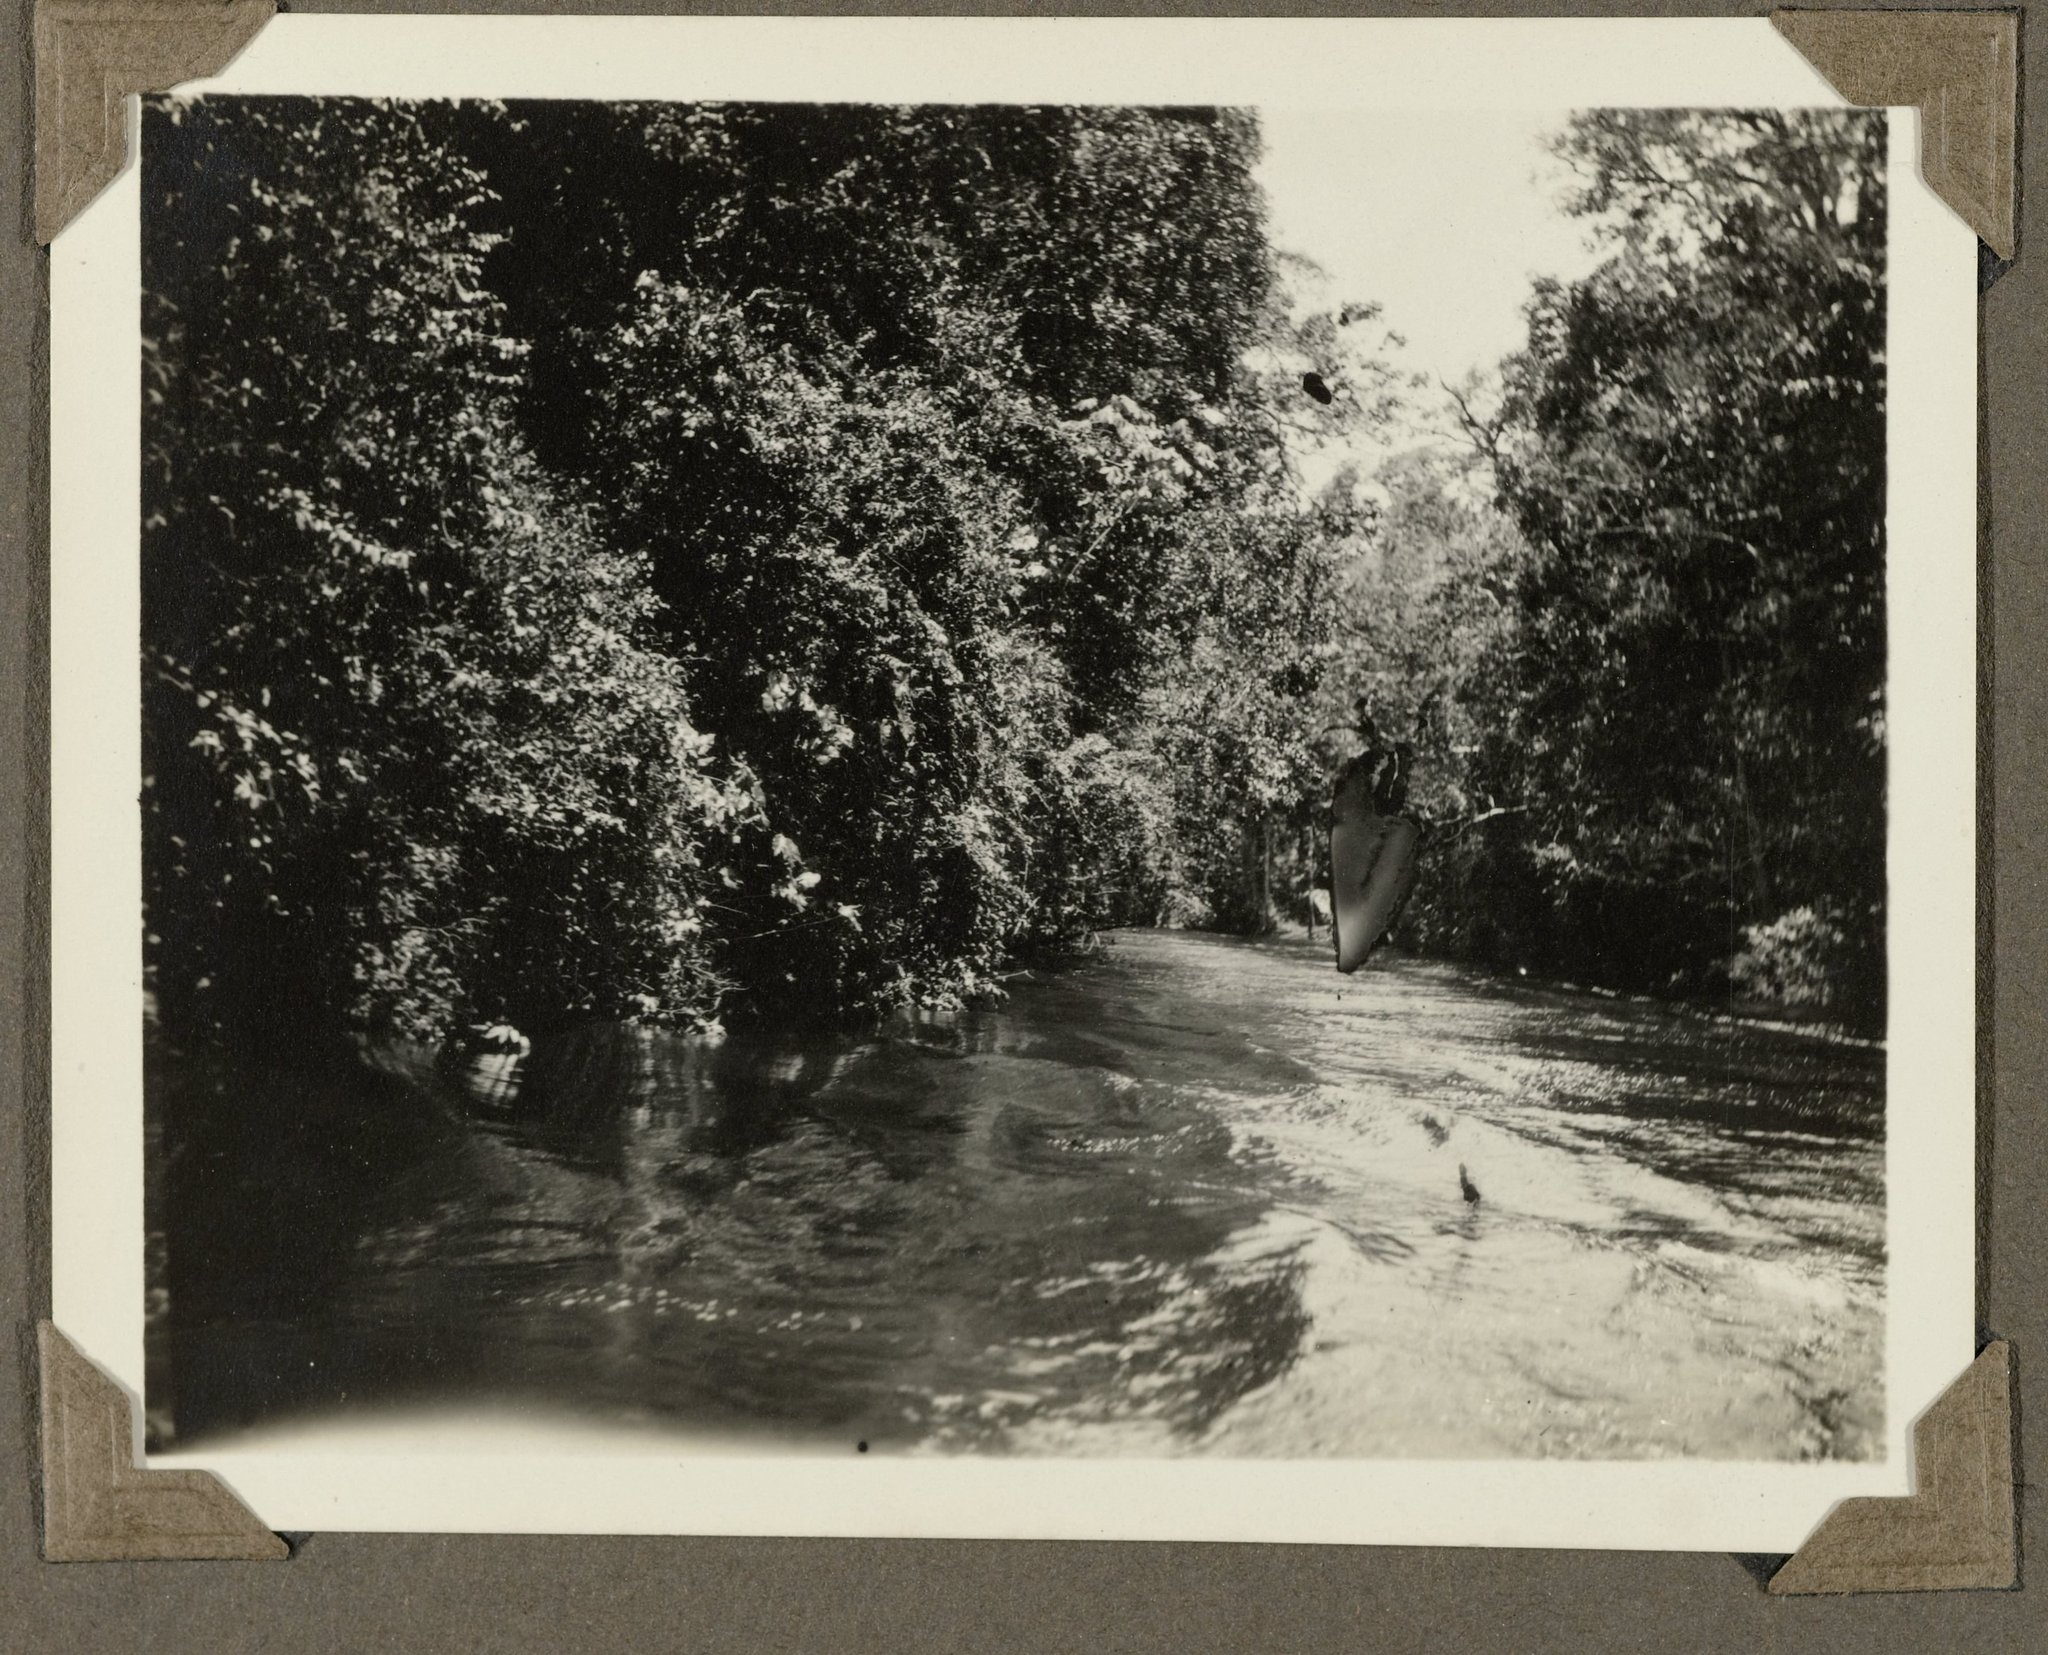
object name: photograph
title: Rivier in Suriname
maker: Anonymous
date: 1925-1927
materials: photographic support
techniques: photography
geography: suriname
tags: landscapes in tropical and sub-tropical regions, suriname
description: Rivier in het binnenland van Suriname. Foto met hoekjes bevestigd op een bladzijde van een albumblad in het fotoalbum over de familie Jetten en het leven en werken in de mijnstad Moengo in Suriname rond 1927.